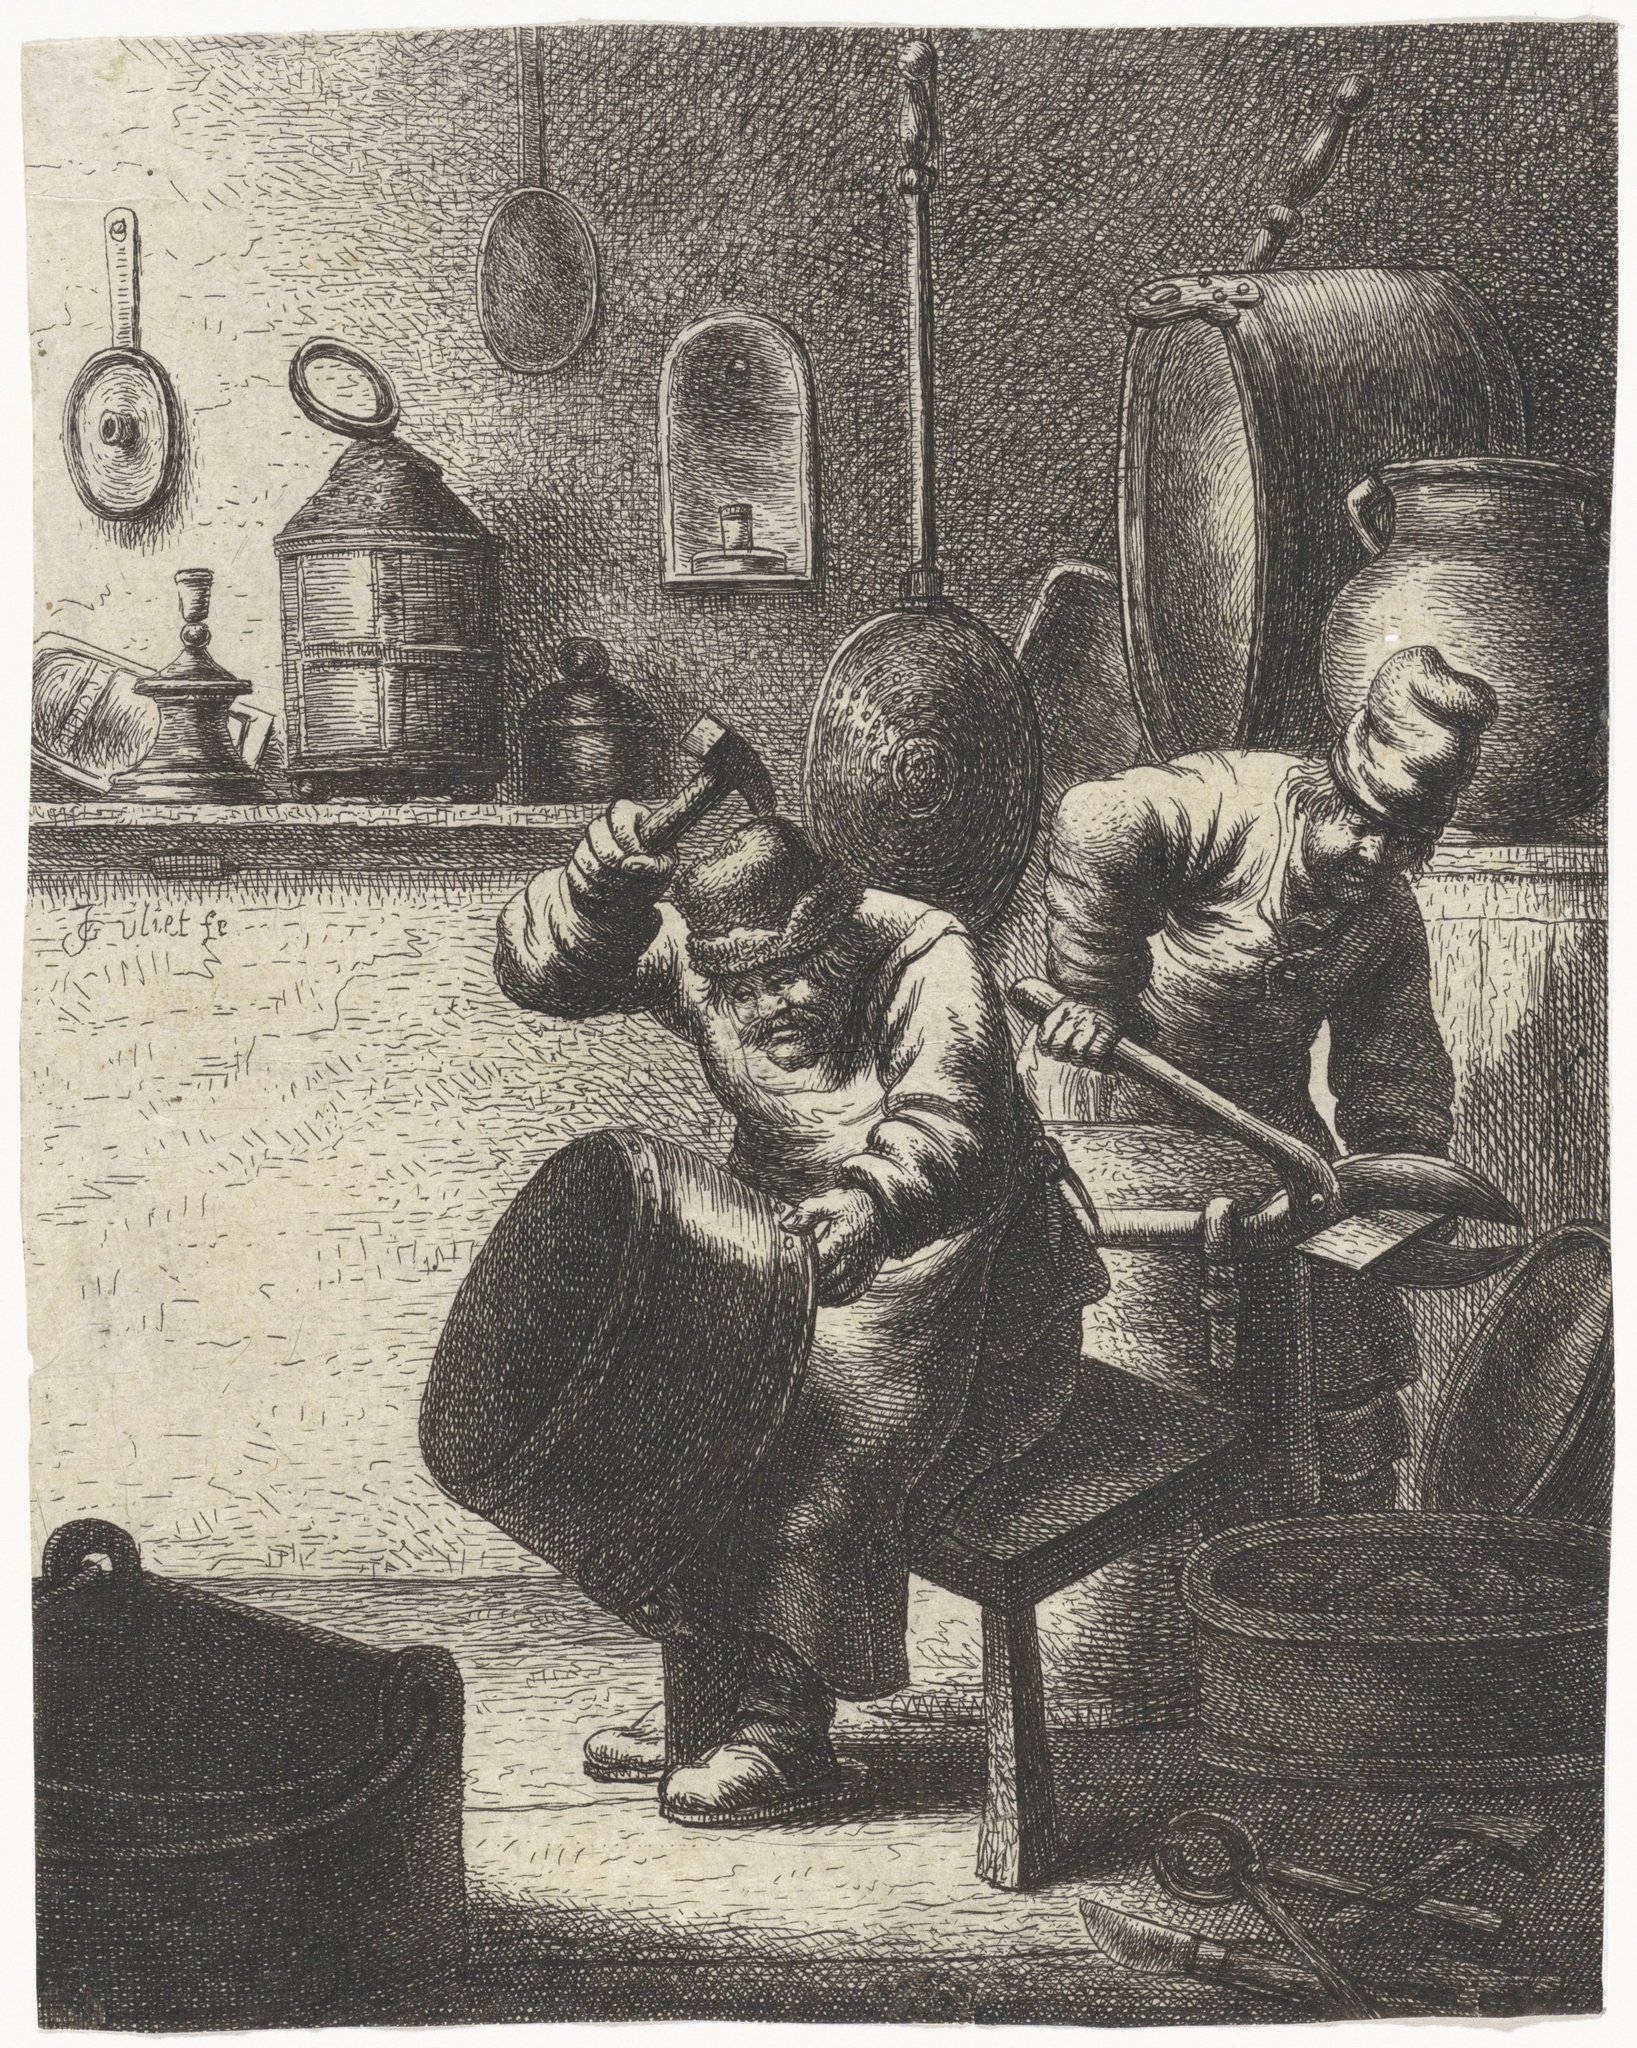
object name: print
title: Beroepen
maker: jan gillisz. van vliet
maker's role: draughtsman, painter, print maker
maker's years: 1600-1668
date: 1635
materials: paper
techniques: etching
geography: leiden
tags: coppersmith, brassworker, industries ~ metal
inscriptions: collector's mark: Lugt 2228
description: Twee koperslagers in een werkplaats; een van hen hamert op een kuip, de ander snijdt een koperplaat.